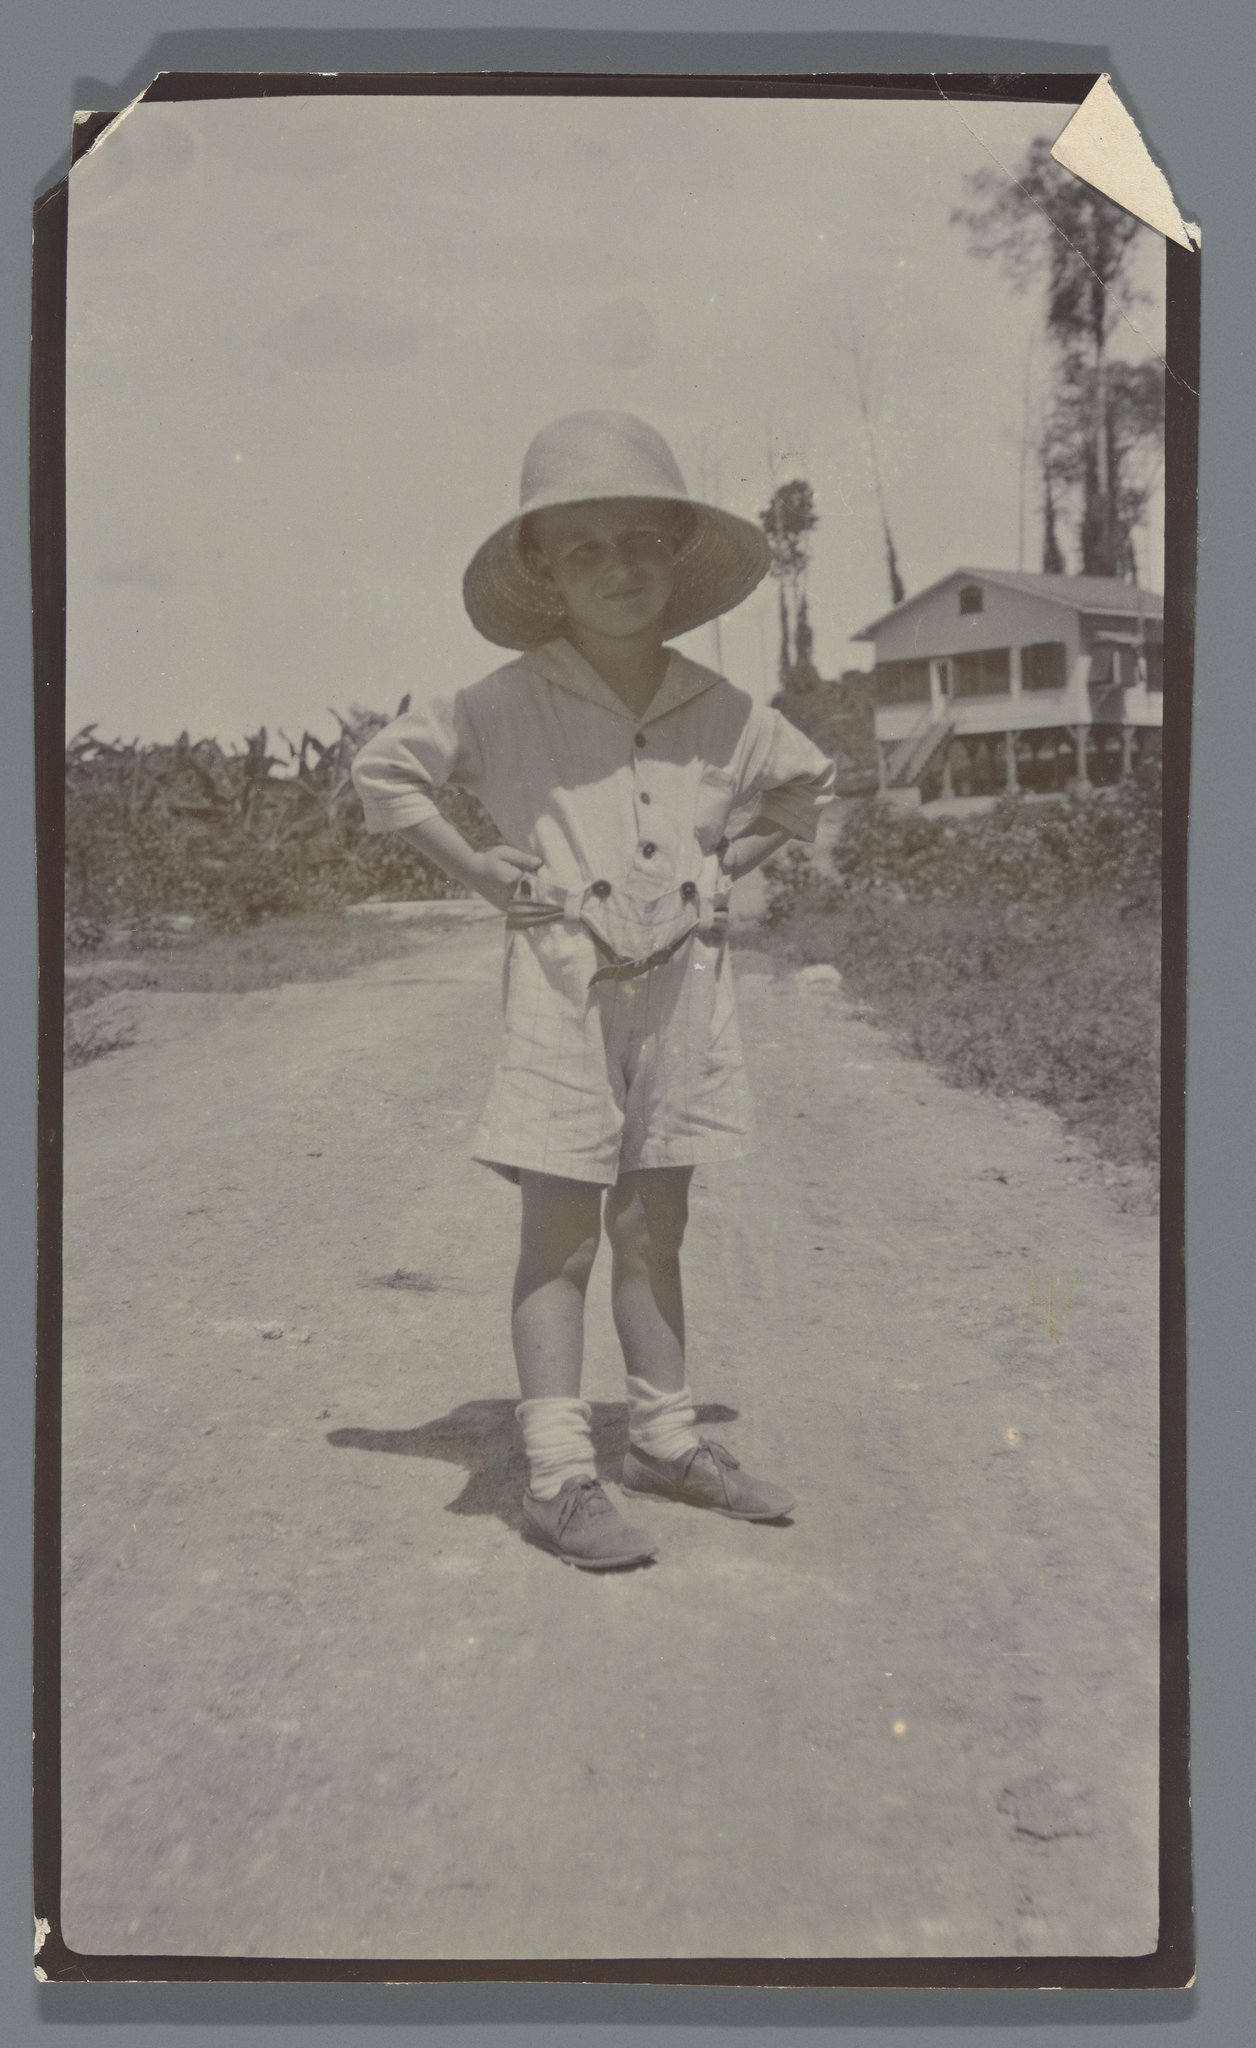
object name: photograph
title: Jongetje met tropenhelm op een weggetje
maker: Anonymous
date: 1925-1927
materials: photographic support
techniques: photography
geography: suriname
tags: jetten, familie, moengo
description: Jongetje met tropenhelm op een weggetje. Onderdeel van het ensemble met foto's van de familie van ingenieur Jetten in de mijnbouwstad Moengo in Suriname.